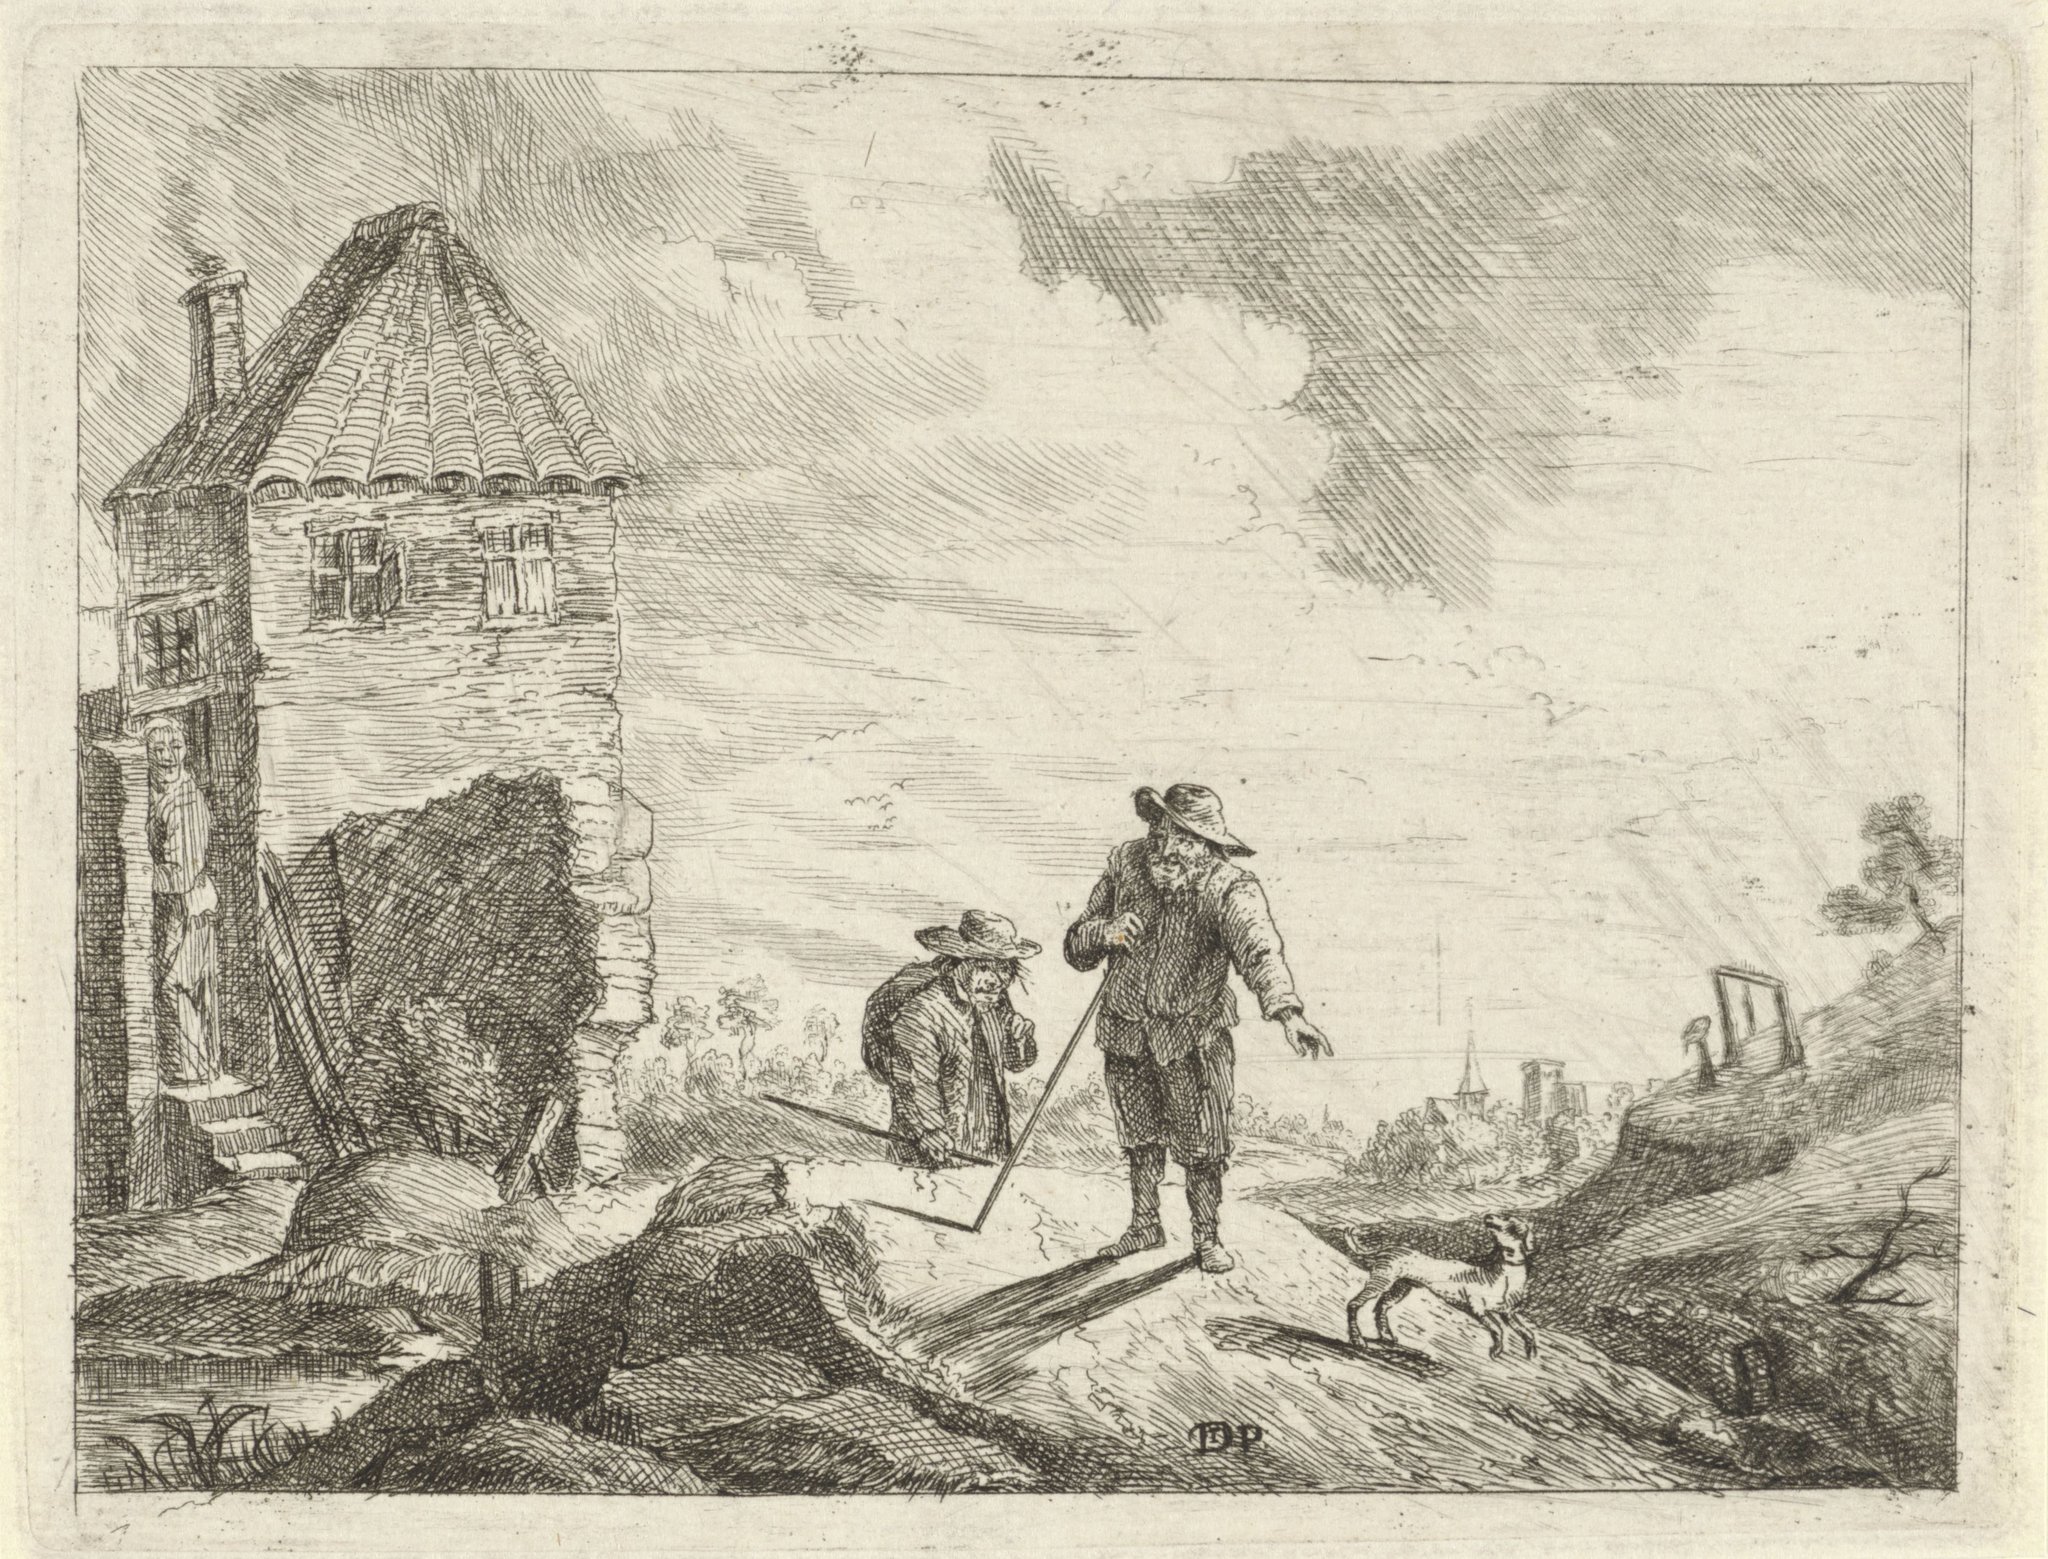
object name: print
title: Twee boeren met een hond op een landweg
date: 1704-1765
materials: paper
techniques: etching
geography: southern netherlands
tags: landscapes in the temperate zone, dog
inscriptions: collector's mark: Lugt 2228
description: Landschap met twee boeren en een hond op een landweg. Links een woning met een man op een trapje. Rechts op een heuvel een man aan een galg.